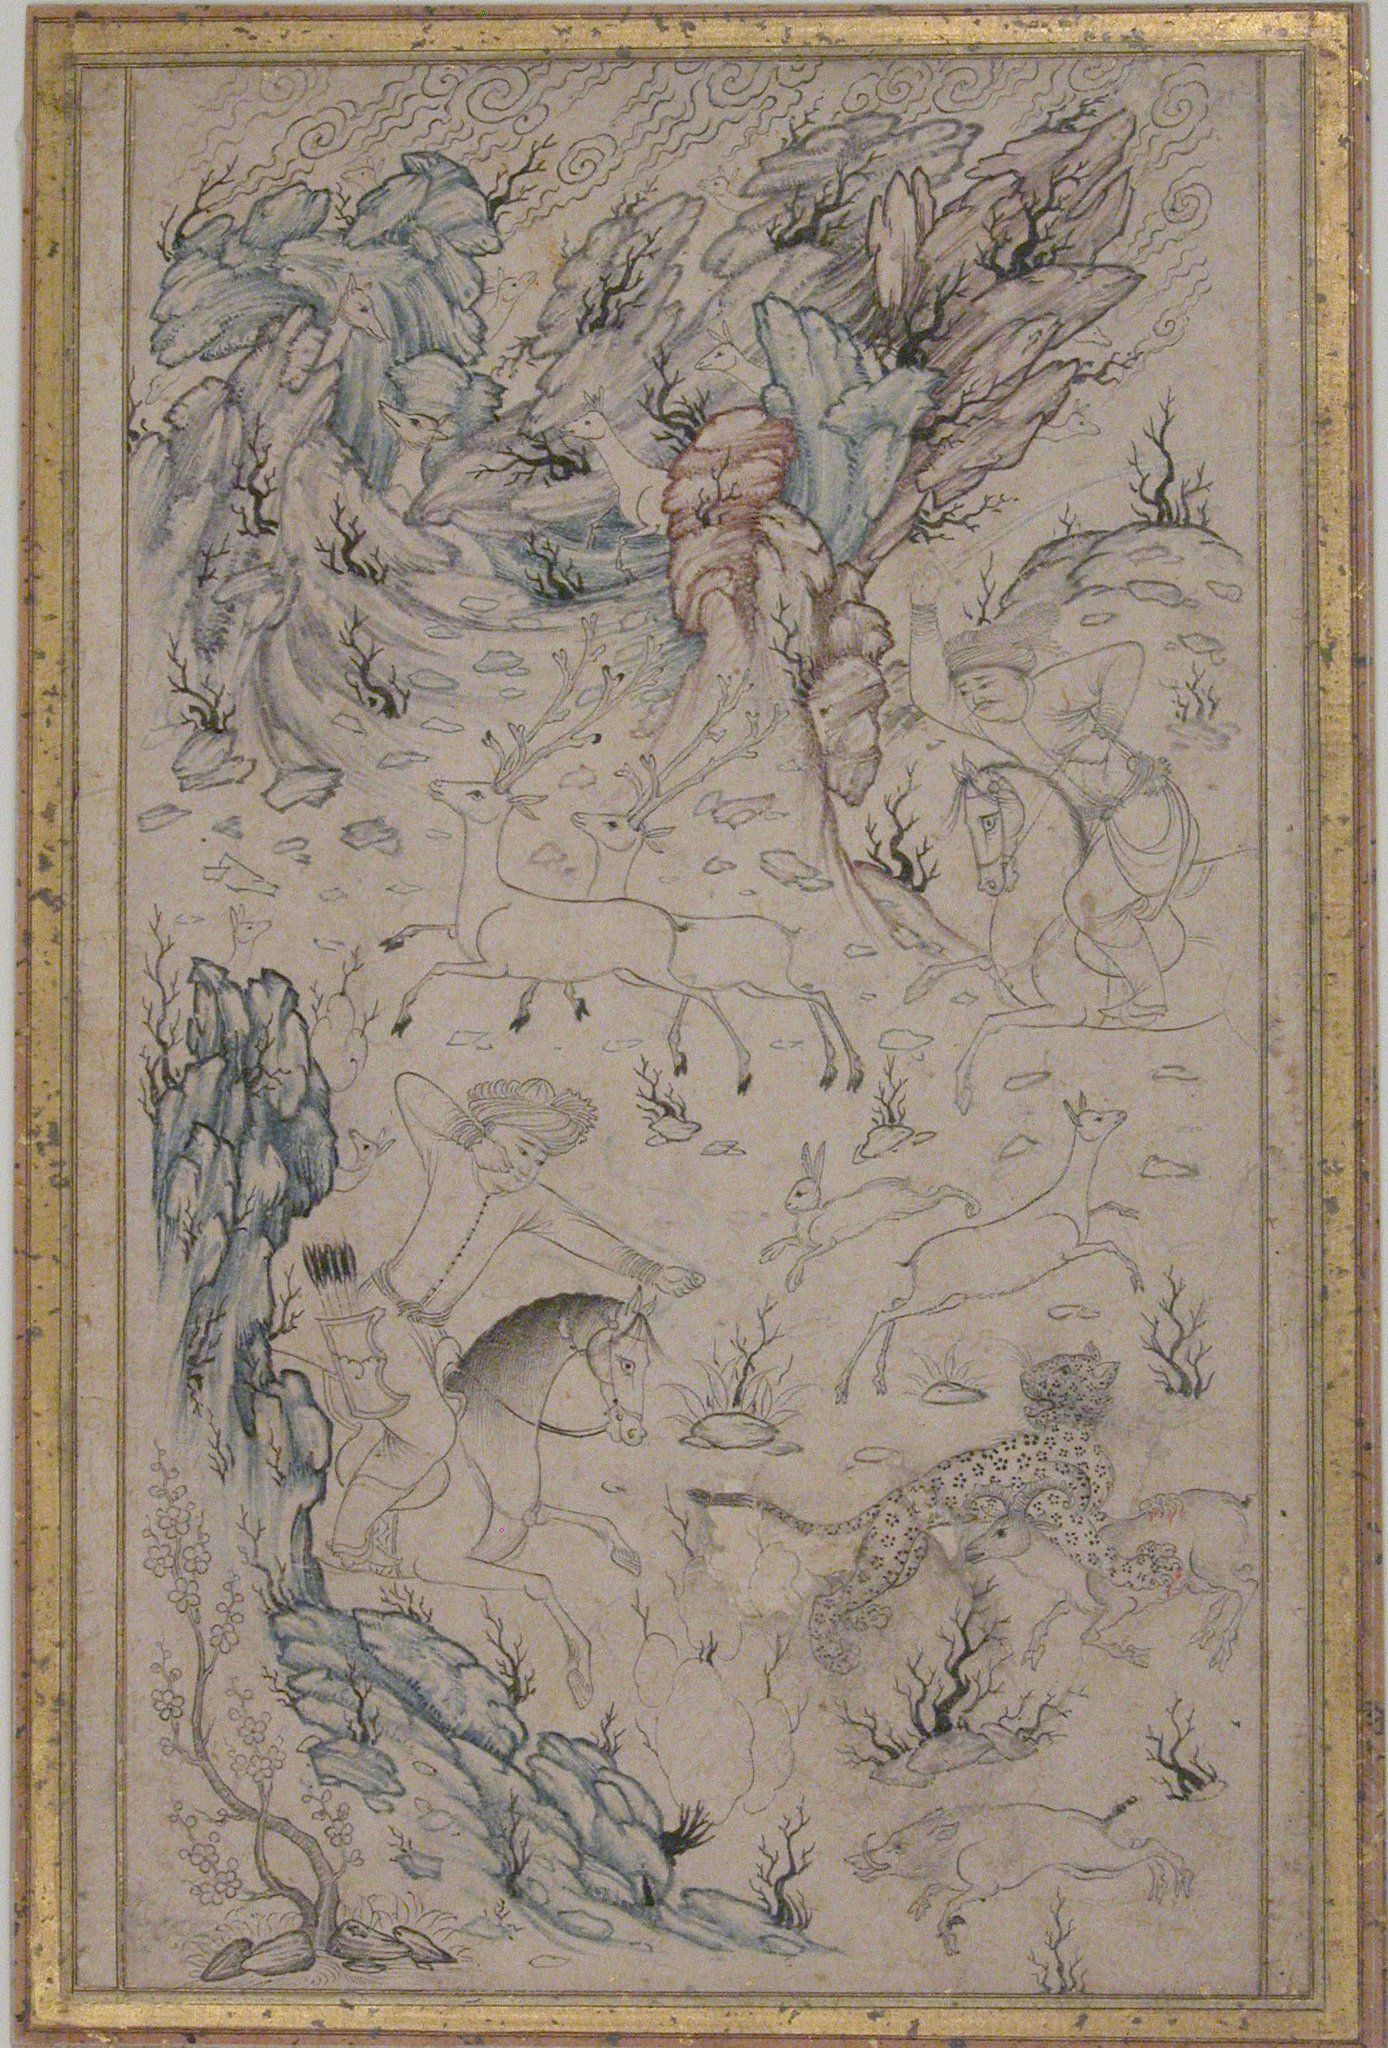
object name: illustrated single work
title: Hunting Scene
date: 1567-1600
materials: ink, paper, watercolor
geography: iran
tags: men,hunting,cheetahs,deer,horses